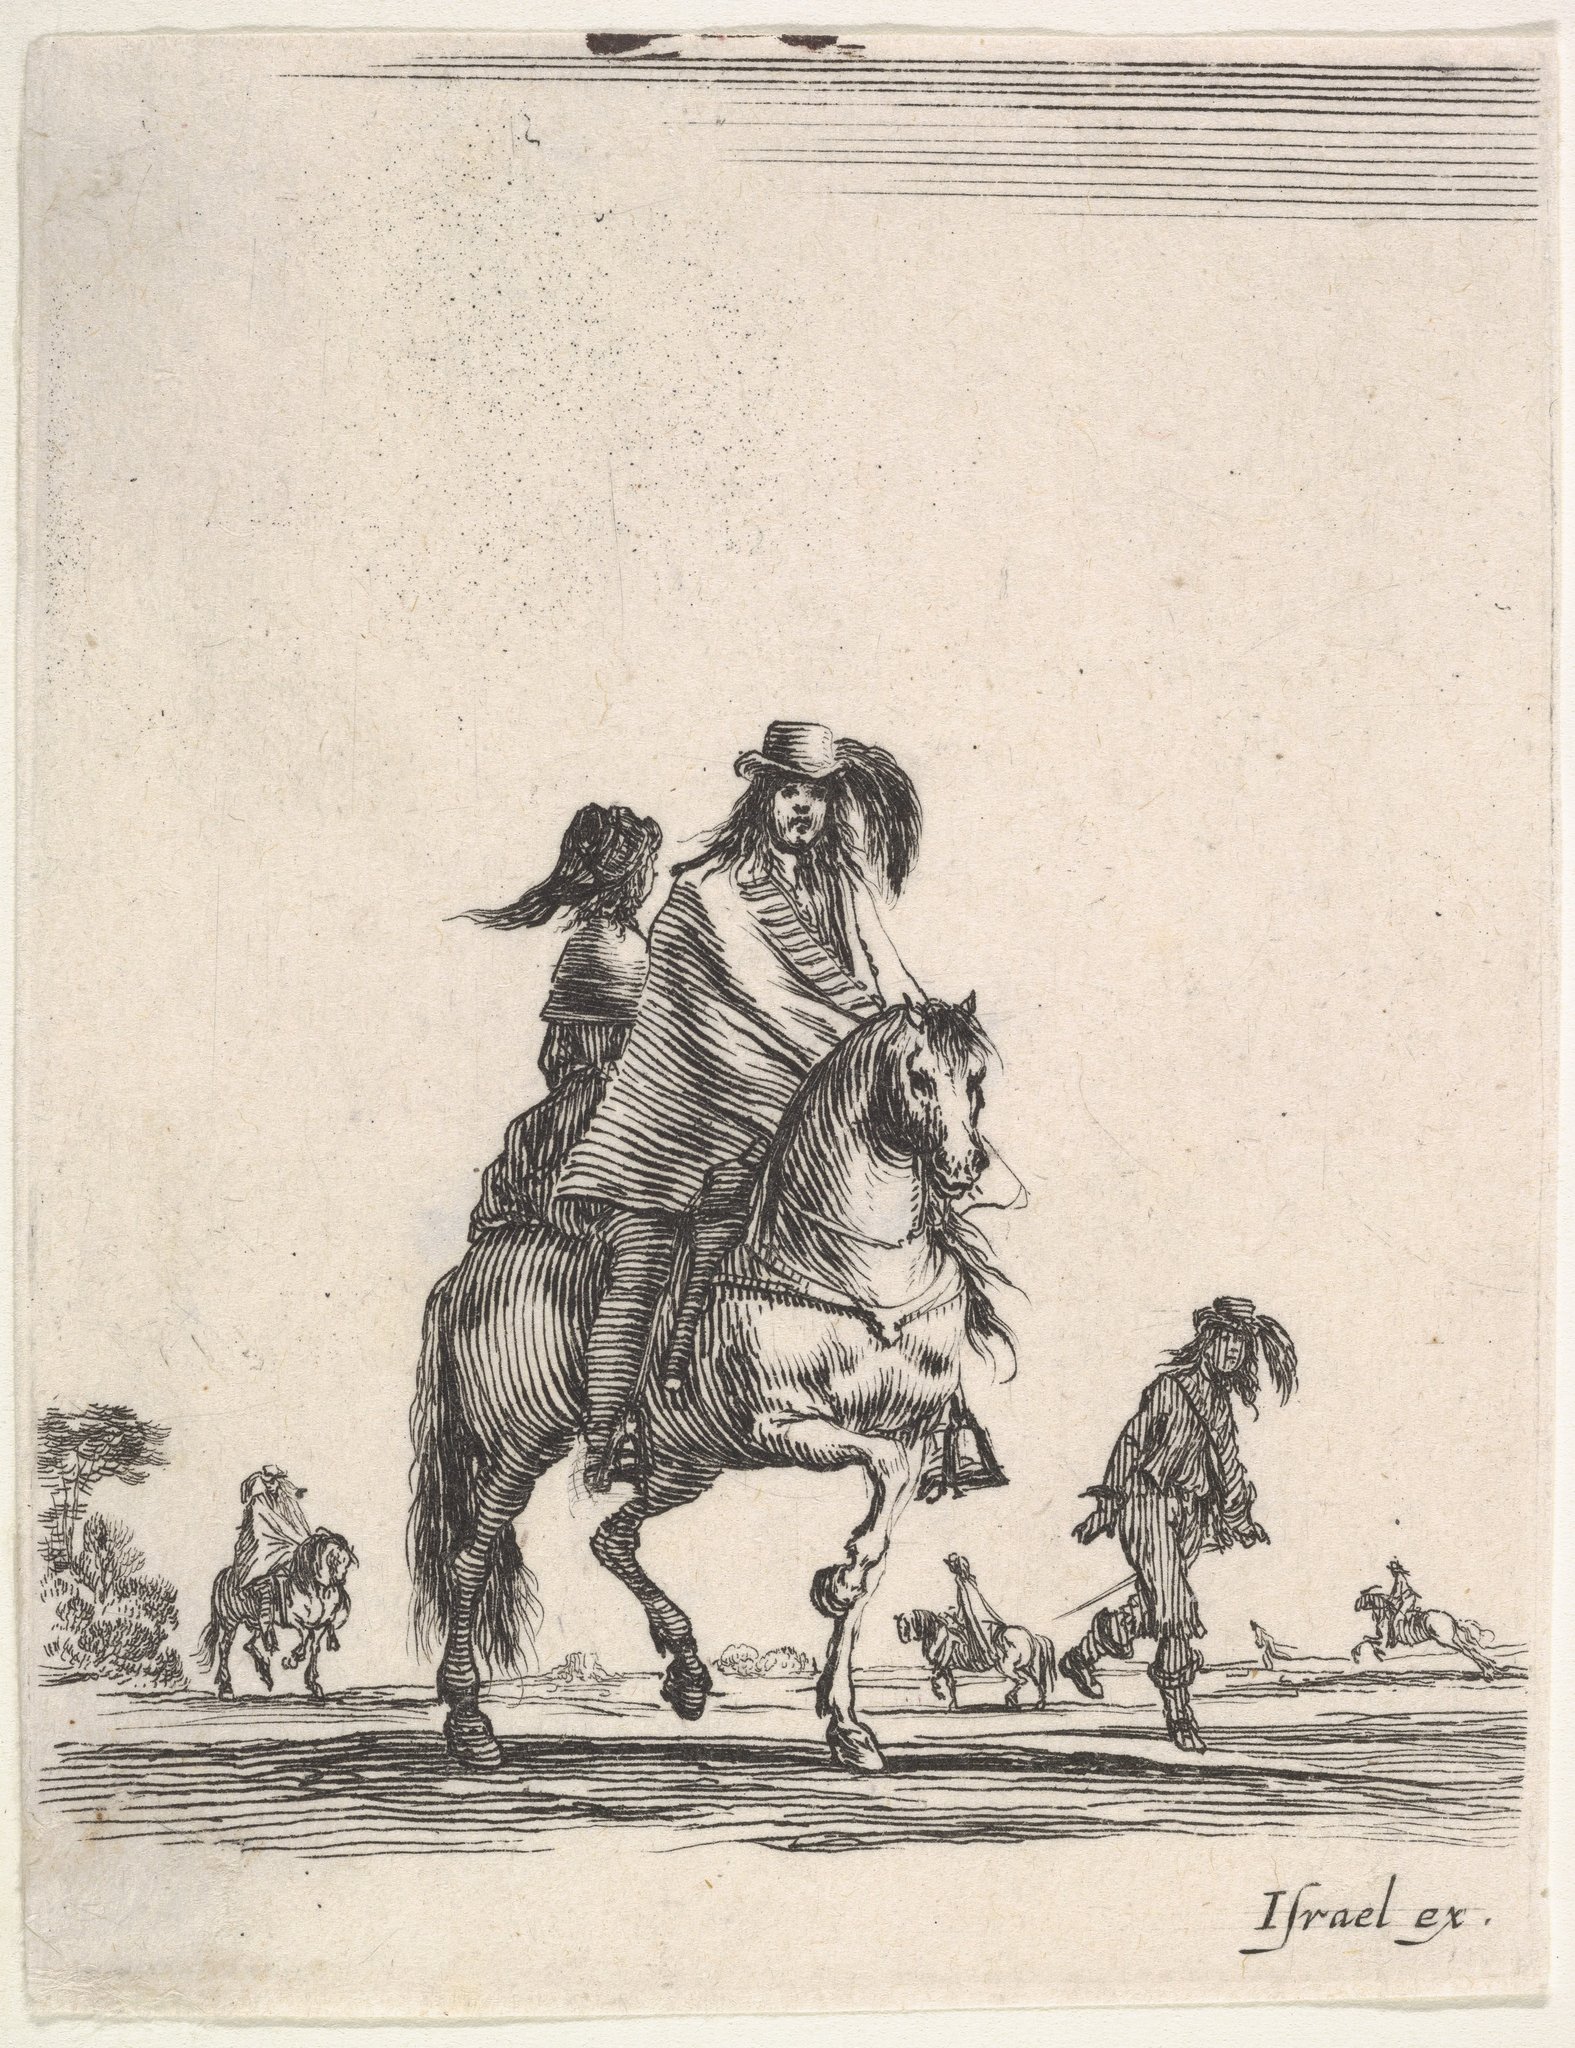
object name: print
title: A horseman and his wife, seated side-saddle behind him, riding towards the right, other horsemen and footsoldiers in the background, from "Various cavalry exercises" (Diverses exercices de cavalerie)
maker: stefano della bella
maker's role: artist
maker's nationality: italian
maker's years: 1610-1664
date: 1642-1645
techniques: etching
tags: men,women,horses